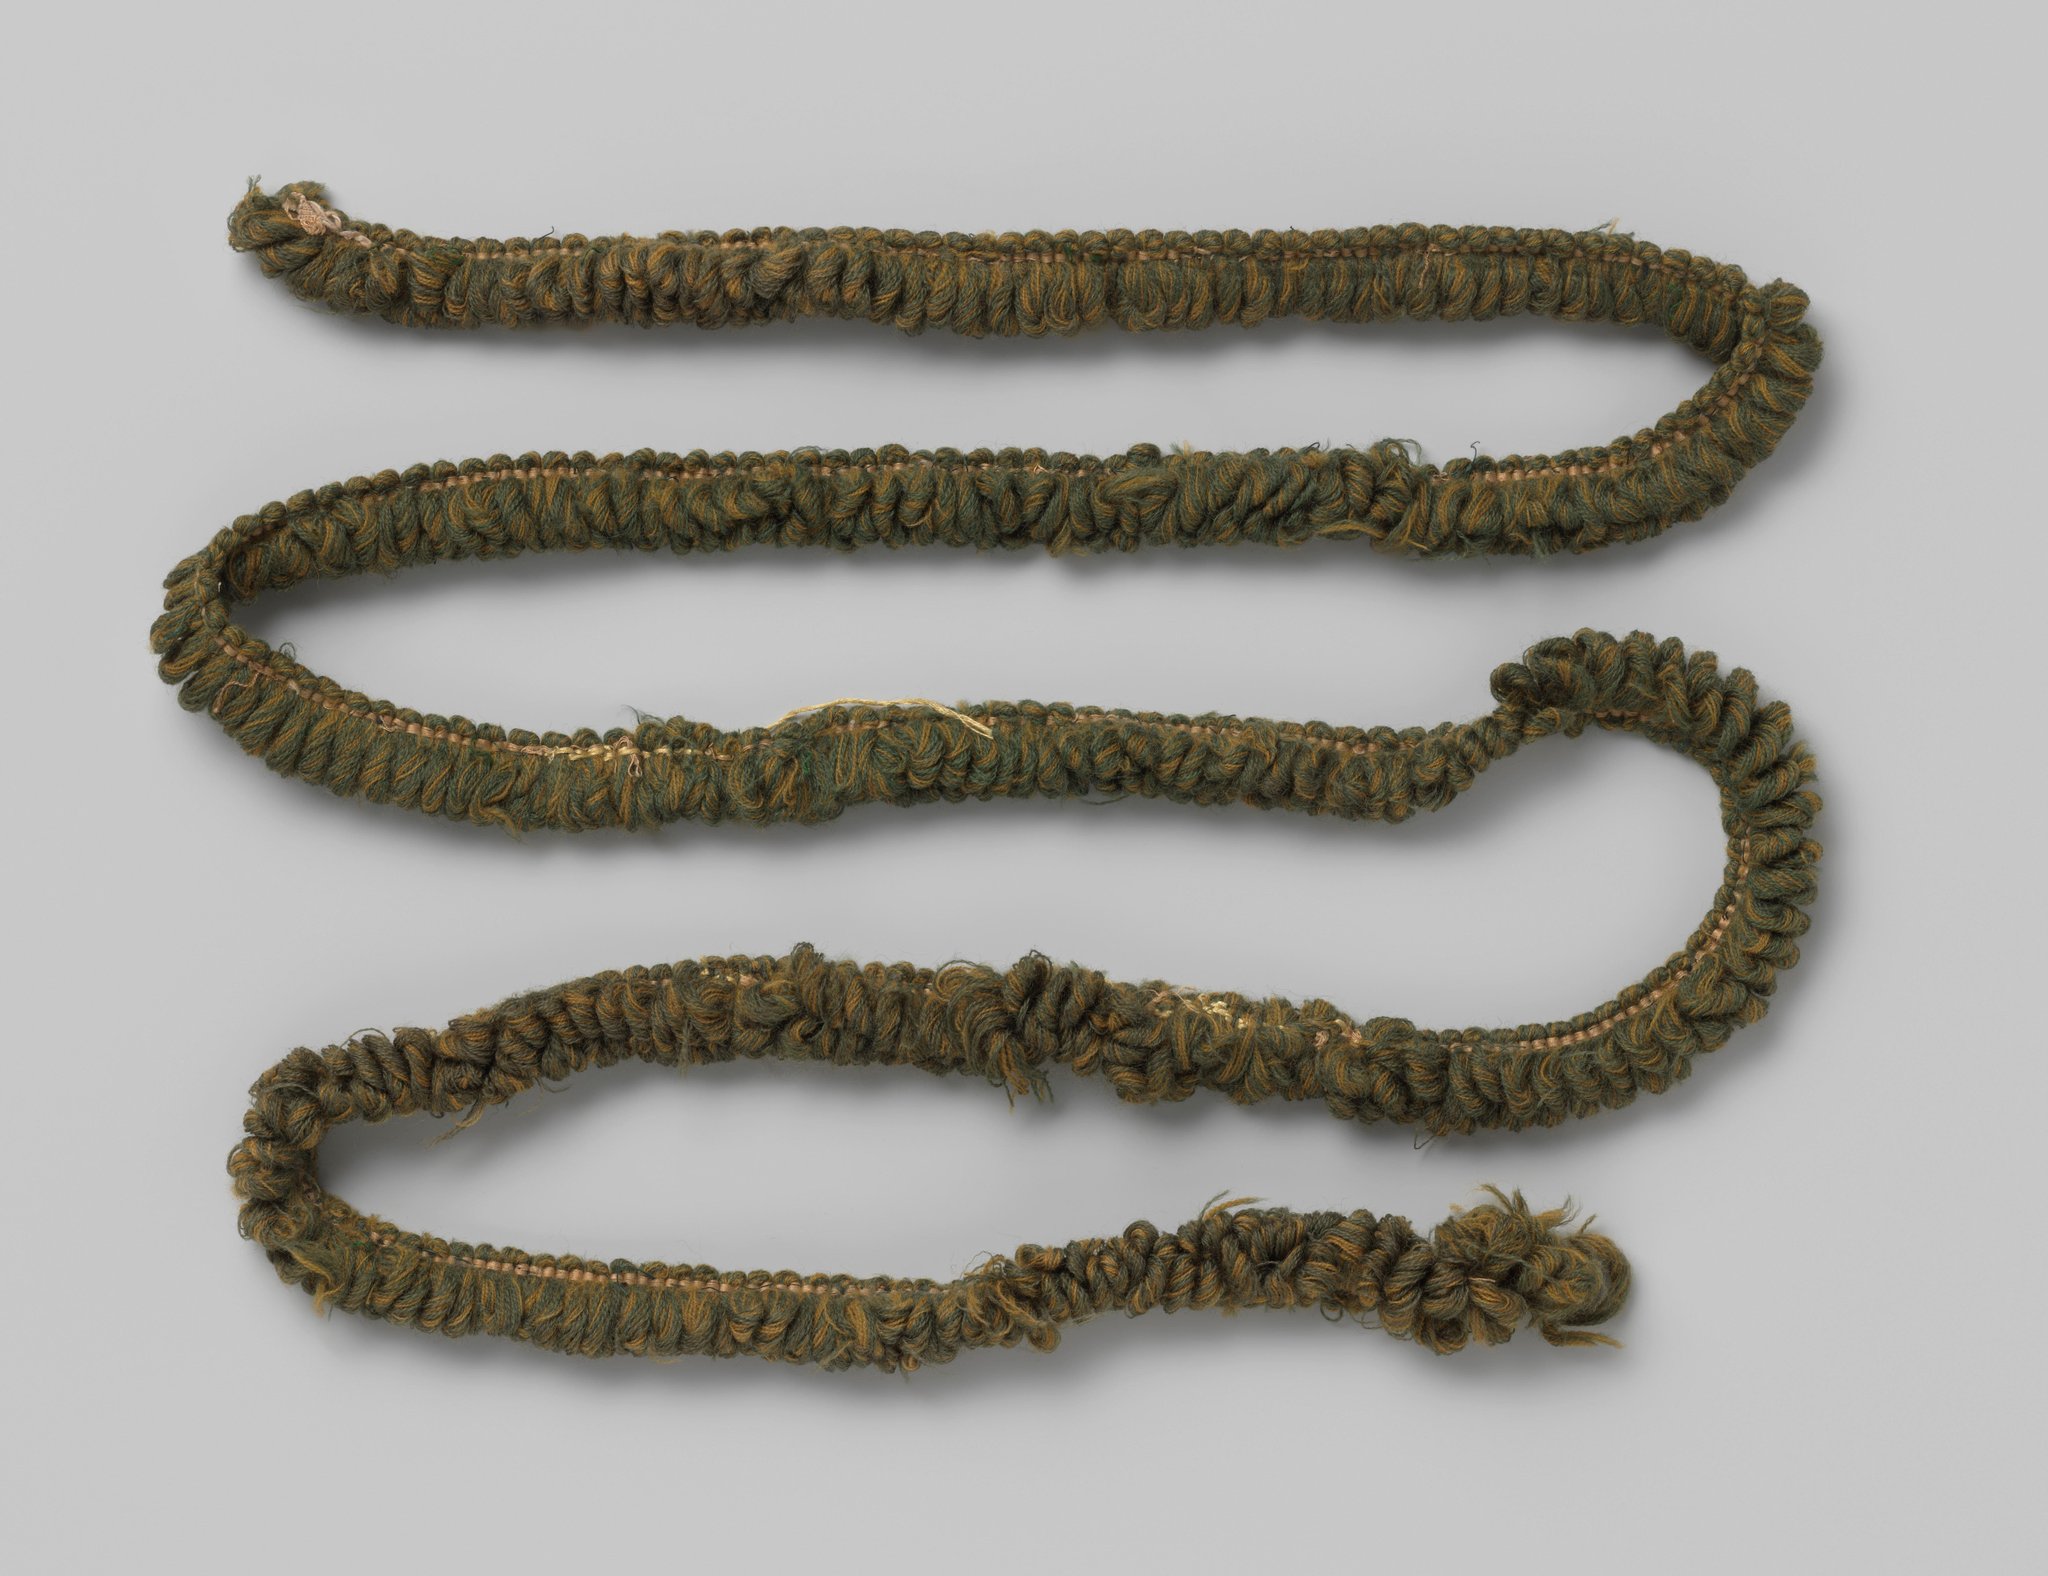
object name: fringe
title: Franje van een kussen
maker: Anonymous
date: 1632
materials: wool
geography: northern netherlands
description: Franje horend bij een kussenblad van een magistratenkussen van tapijtweefsel met het gemeentewapen van de Rijp en als schildhouders twee leeuwen.